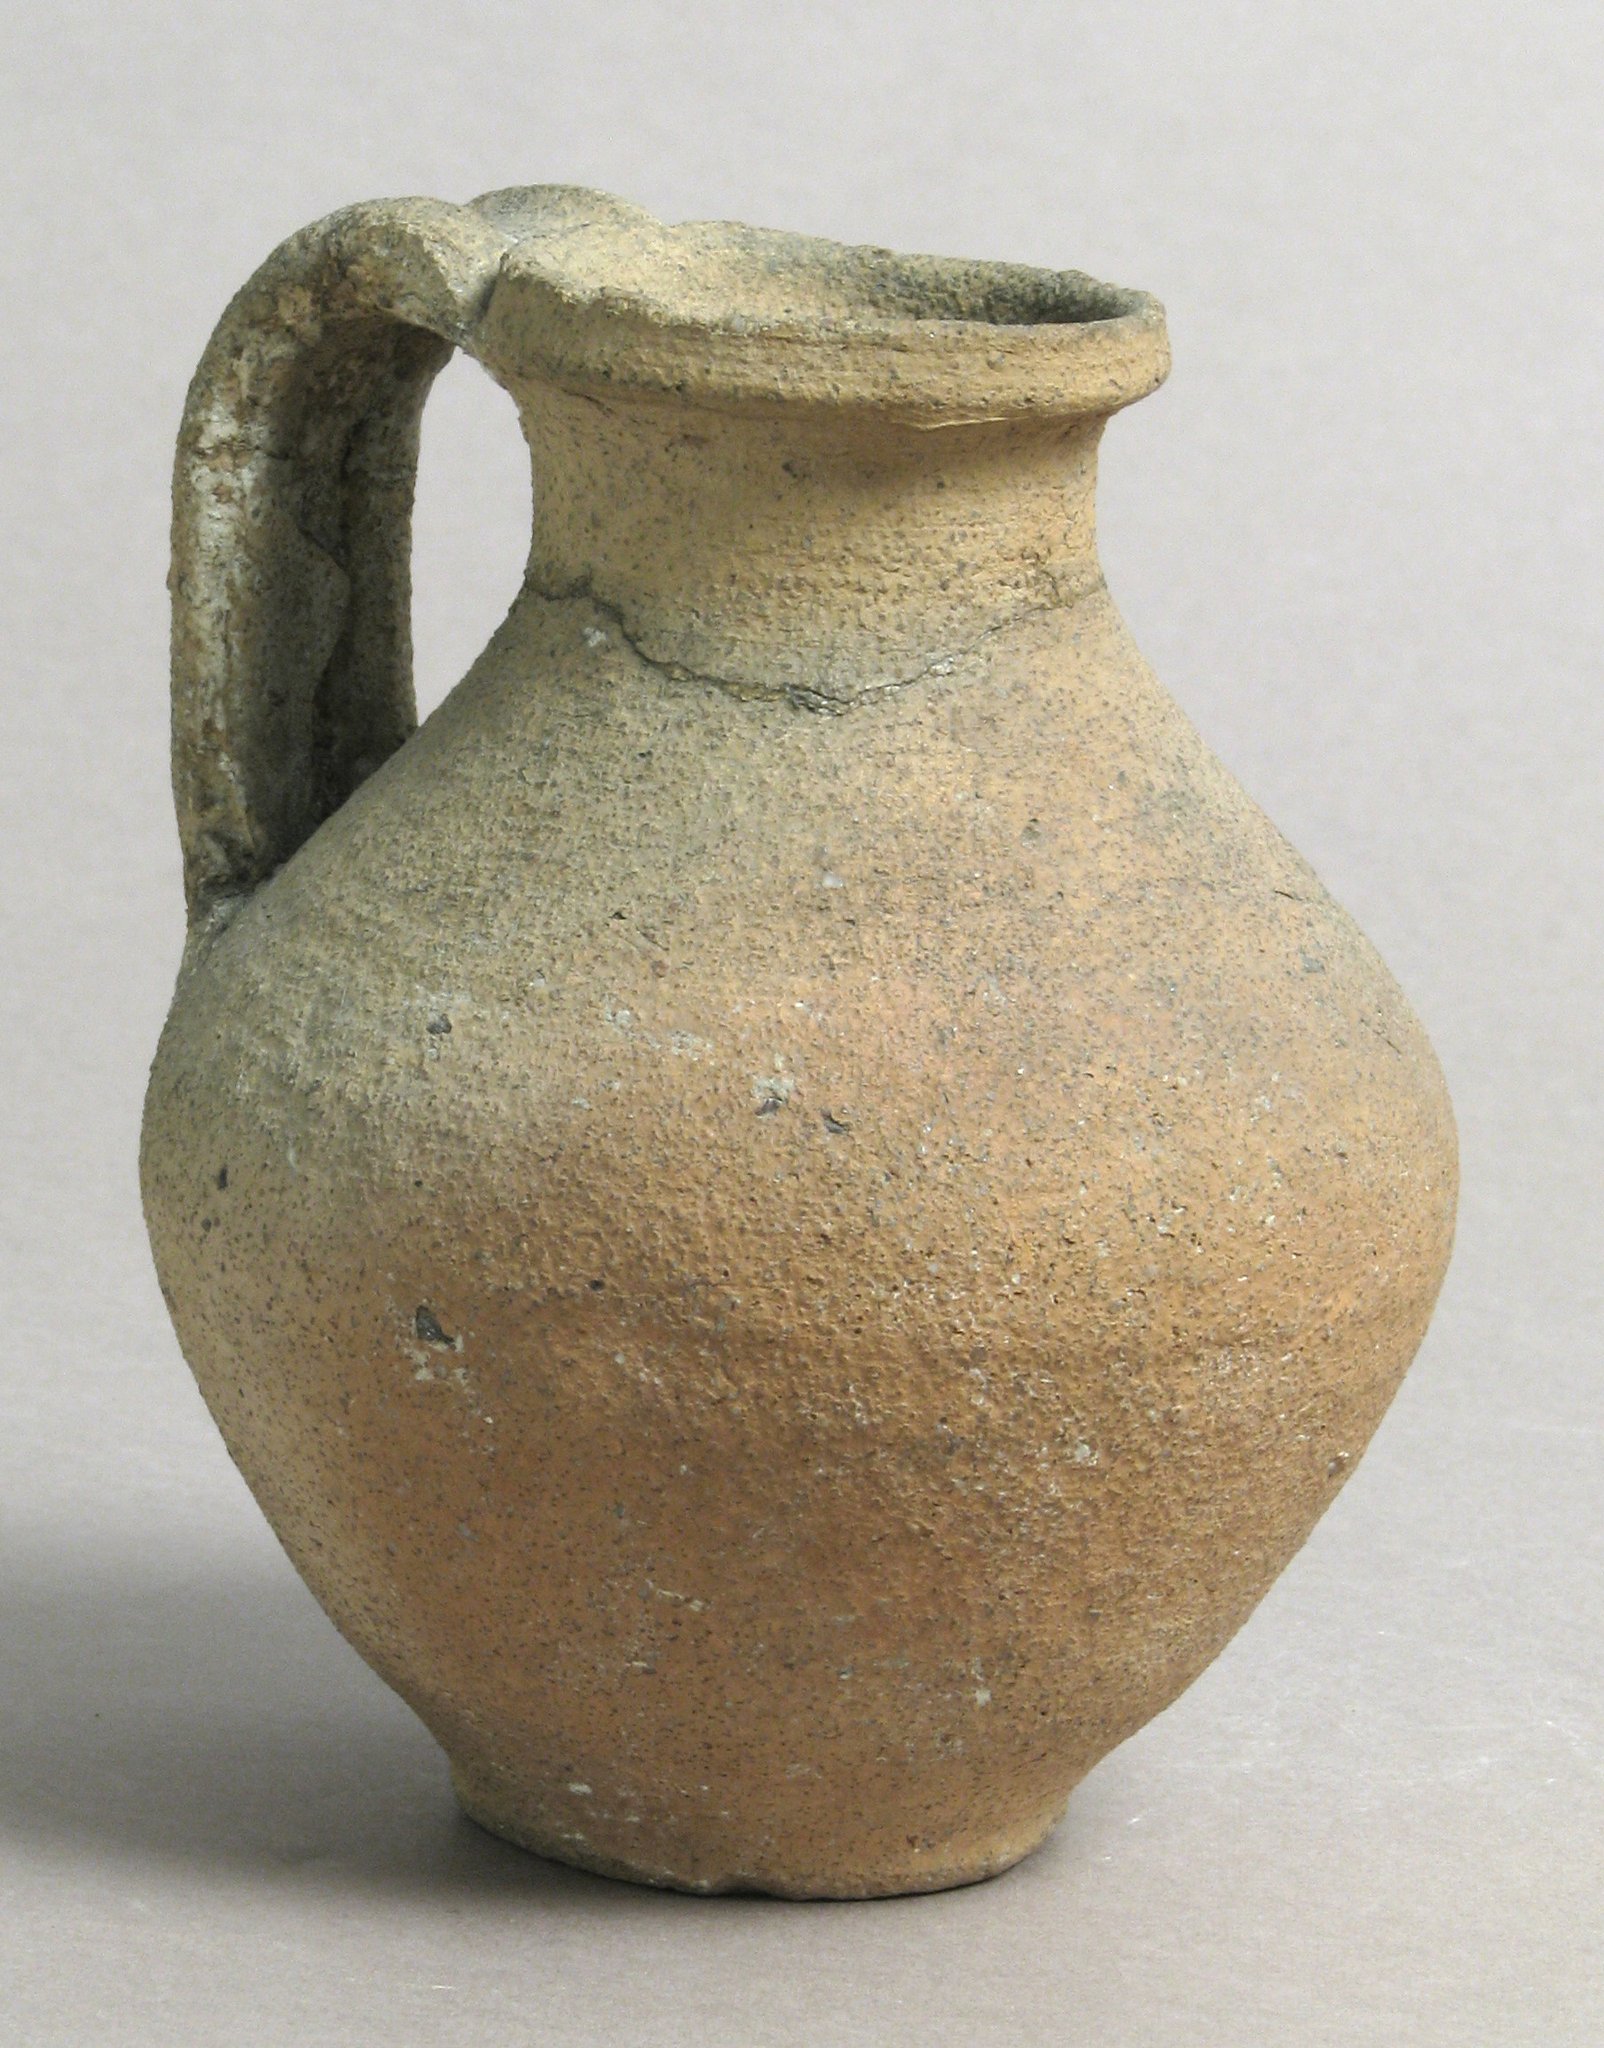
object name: jug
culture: french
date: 1401-1600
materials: earthenware